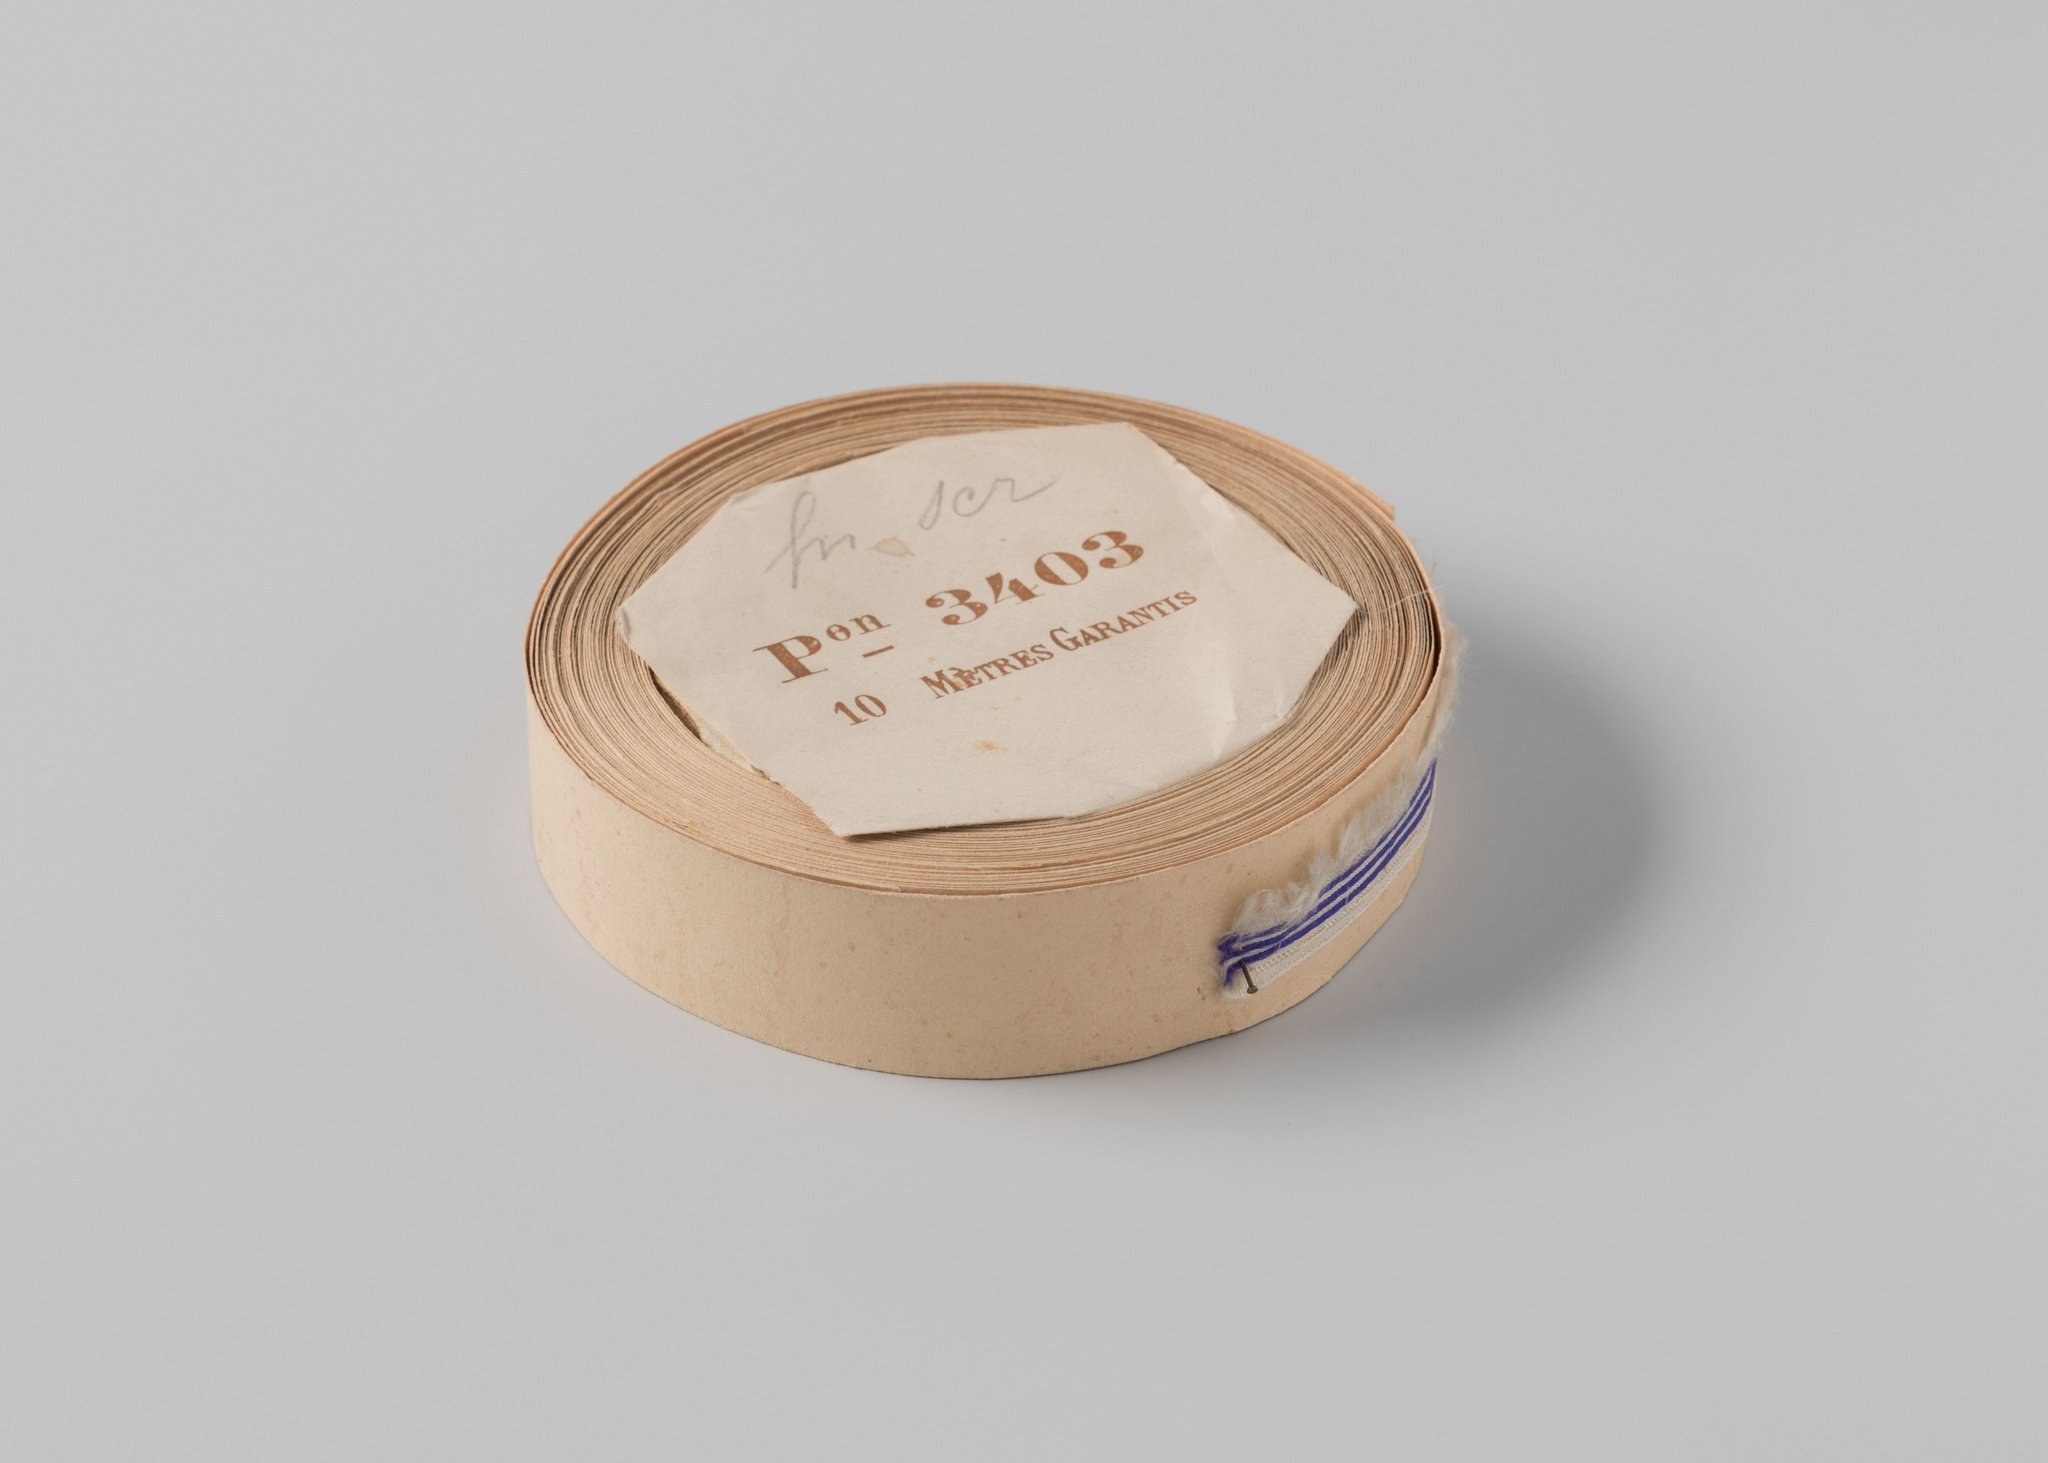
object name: braid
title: Rol met wit lint met één gerafelde zijde en drie blauwe horizontale strepen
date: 1930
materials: cardboard, paper, textile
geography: nijmegen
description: Rol met wit lint met één gerafelde zijde en drie blauwe horizontale strepen.